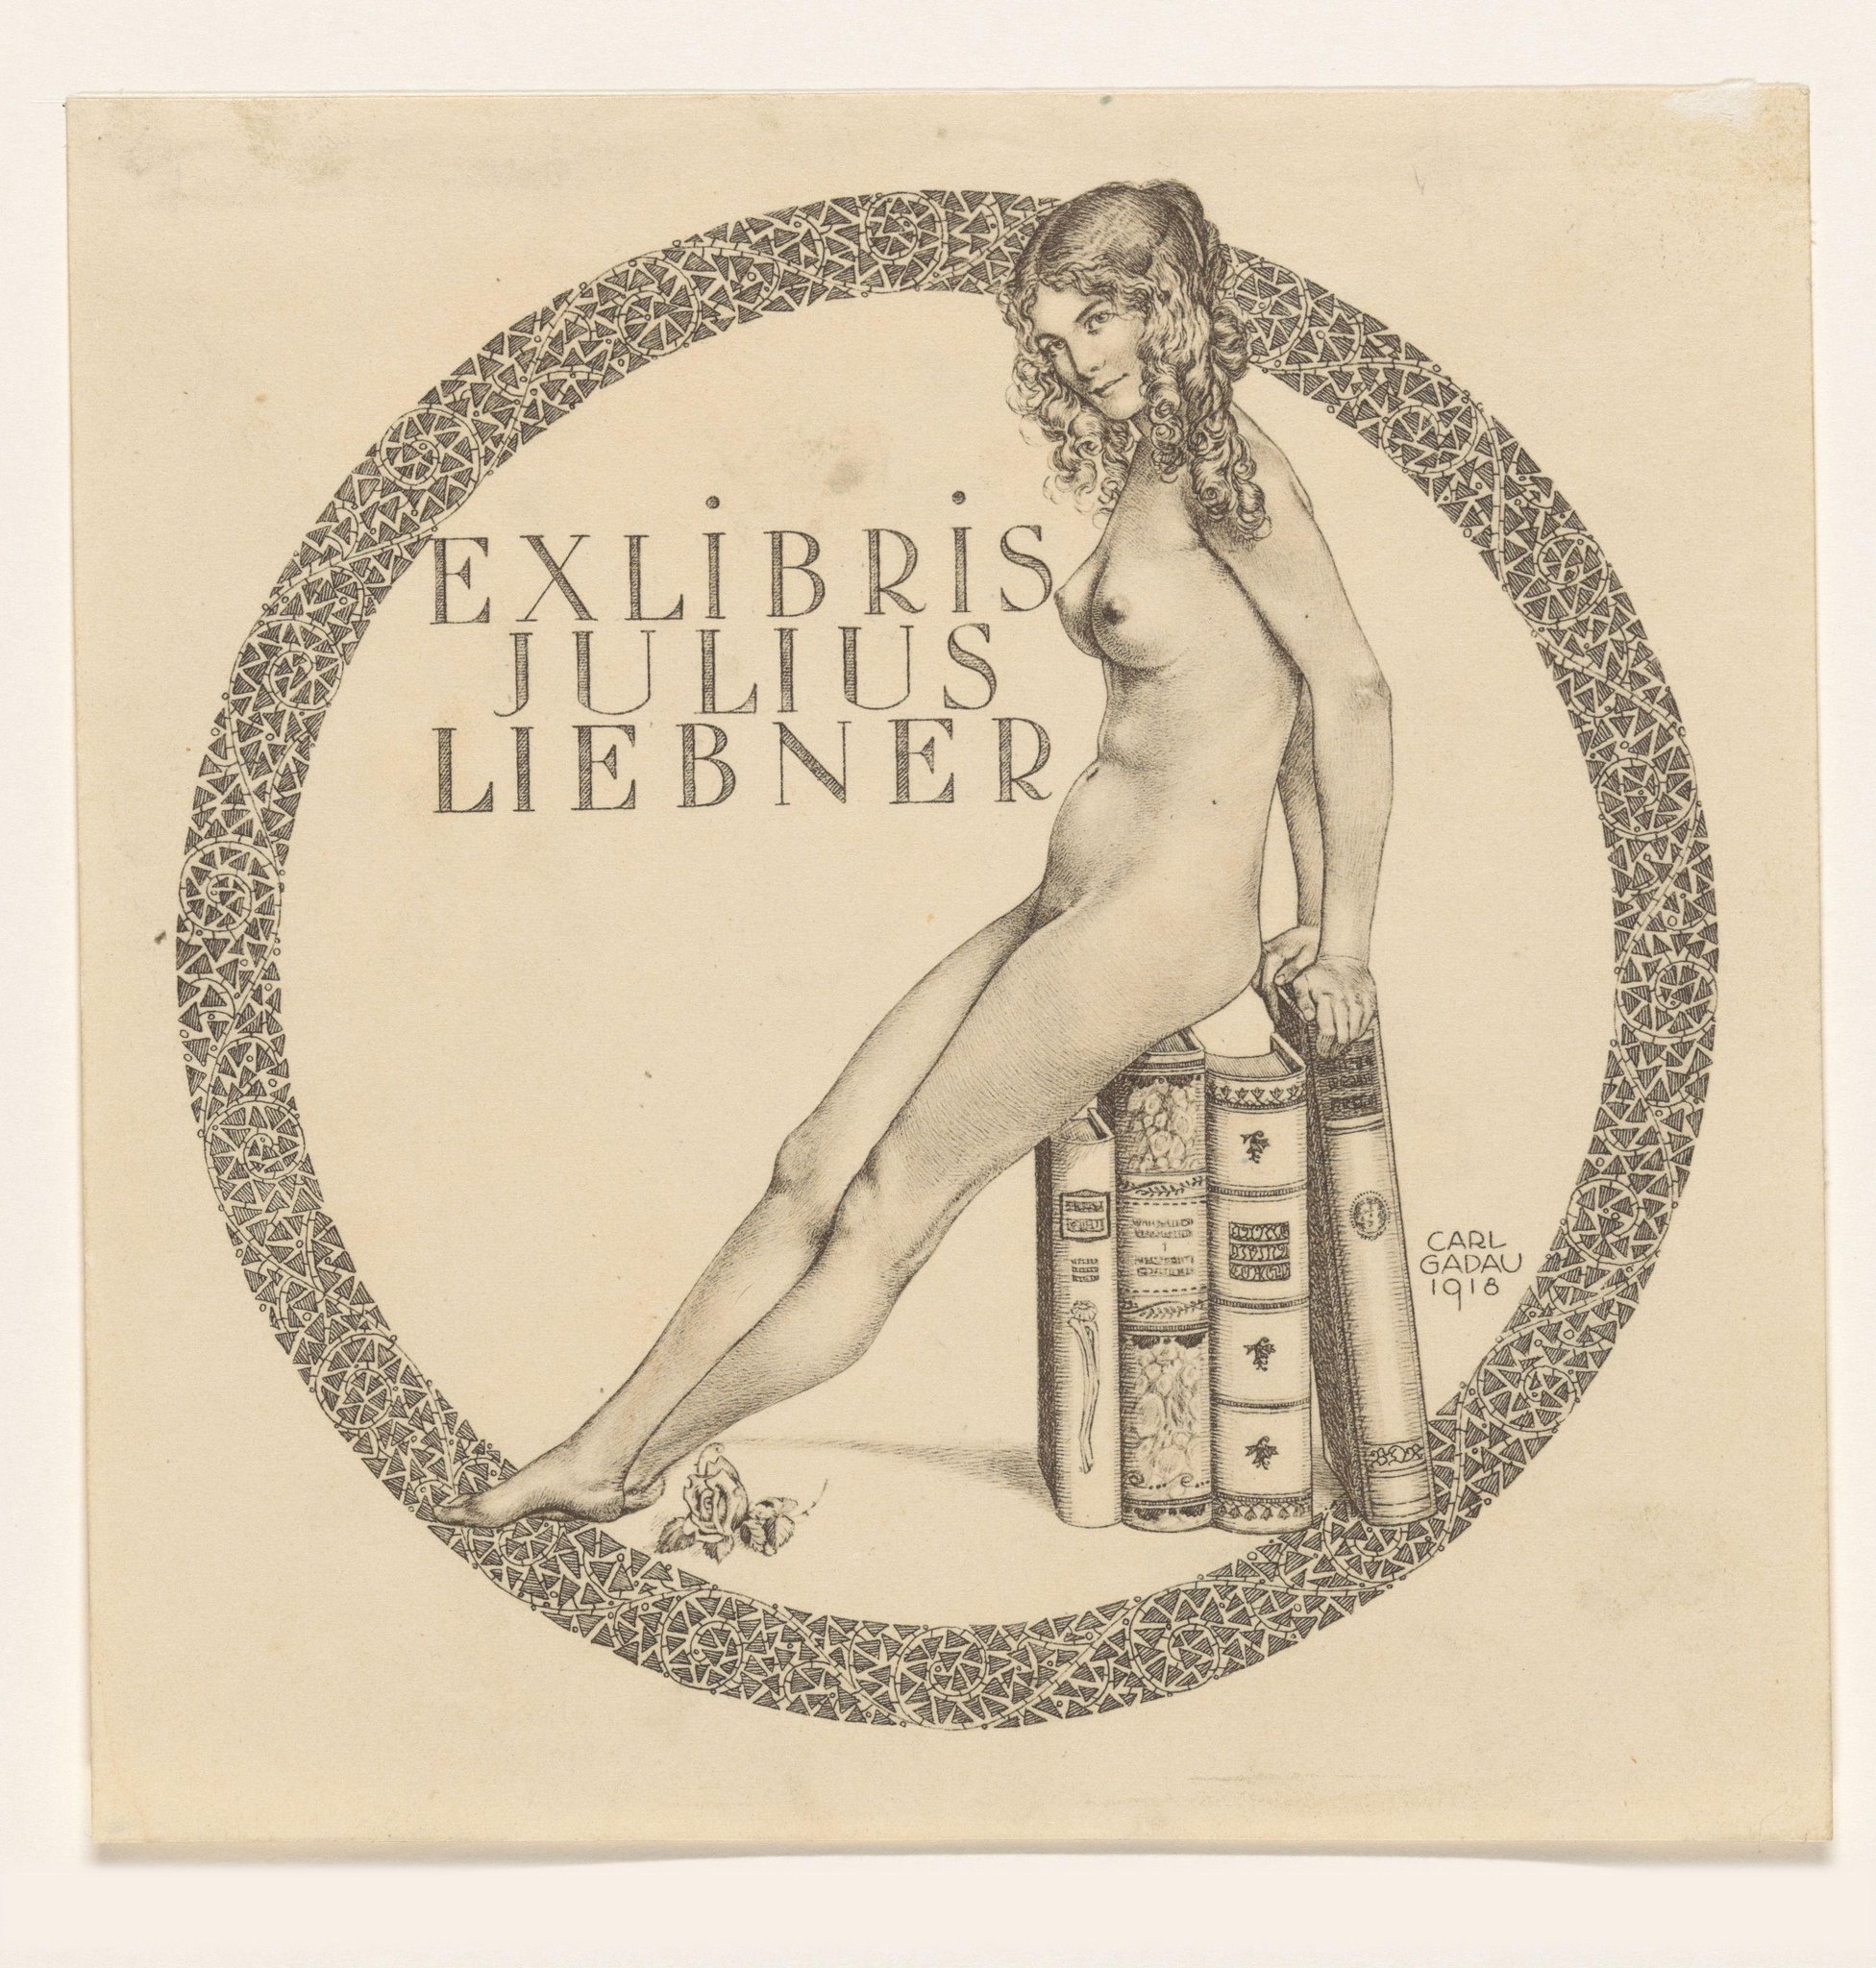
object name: print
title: Ex libris van Julius Liebner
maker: carl otto gadau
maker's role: painter, print maker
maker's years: 1885-1936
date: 1918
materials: paper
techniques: etching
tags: woman (showing herself) undressed, quasi-nude, book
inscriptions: collector's mark: Lugt 4779, collector's mark: Lugt 2228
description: Cirkel met daarin een naakte jonge vrouw zittend op vier folianten, aan haar voet een roos.